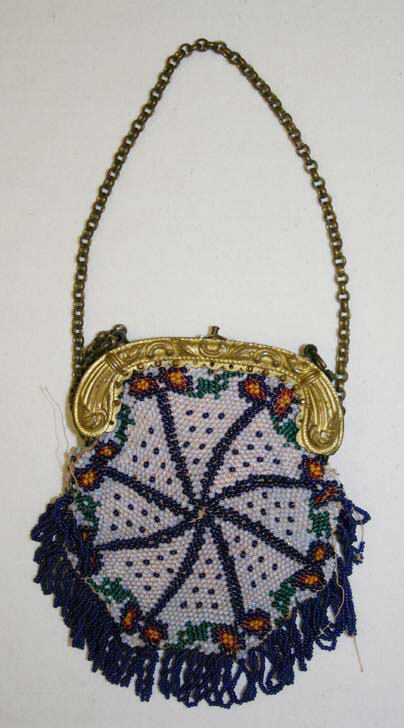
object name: purse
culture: german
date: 1840-1849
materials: glass, metal, silk